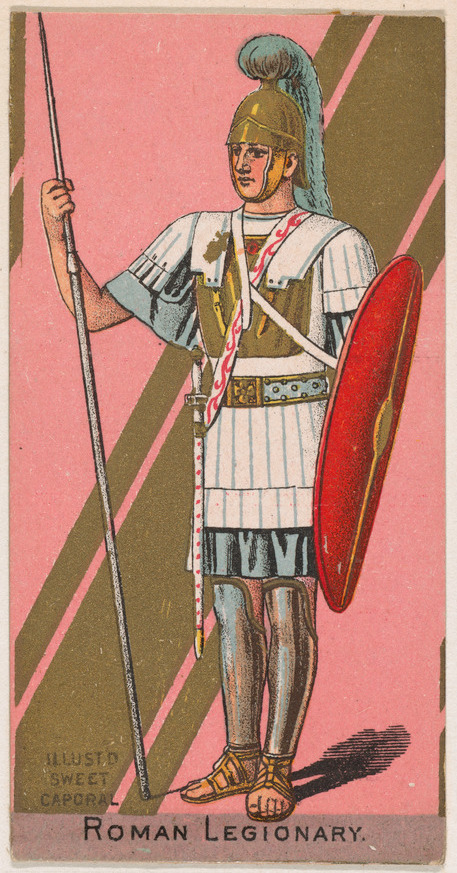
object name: print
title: Roman Legionary, from the Military Series (N224) issued by Kinney Tobacco Company to promote Sweet Caporal Cigarettes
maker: kinney brothers tobacco company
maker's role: publisher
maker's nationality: american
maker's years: 1869-2011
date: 1888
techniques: color lithograph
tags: military,men